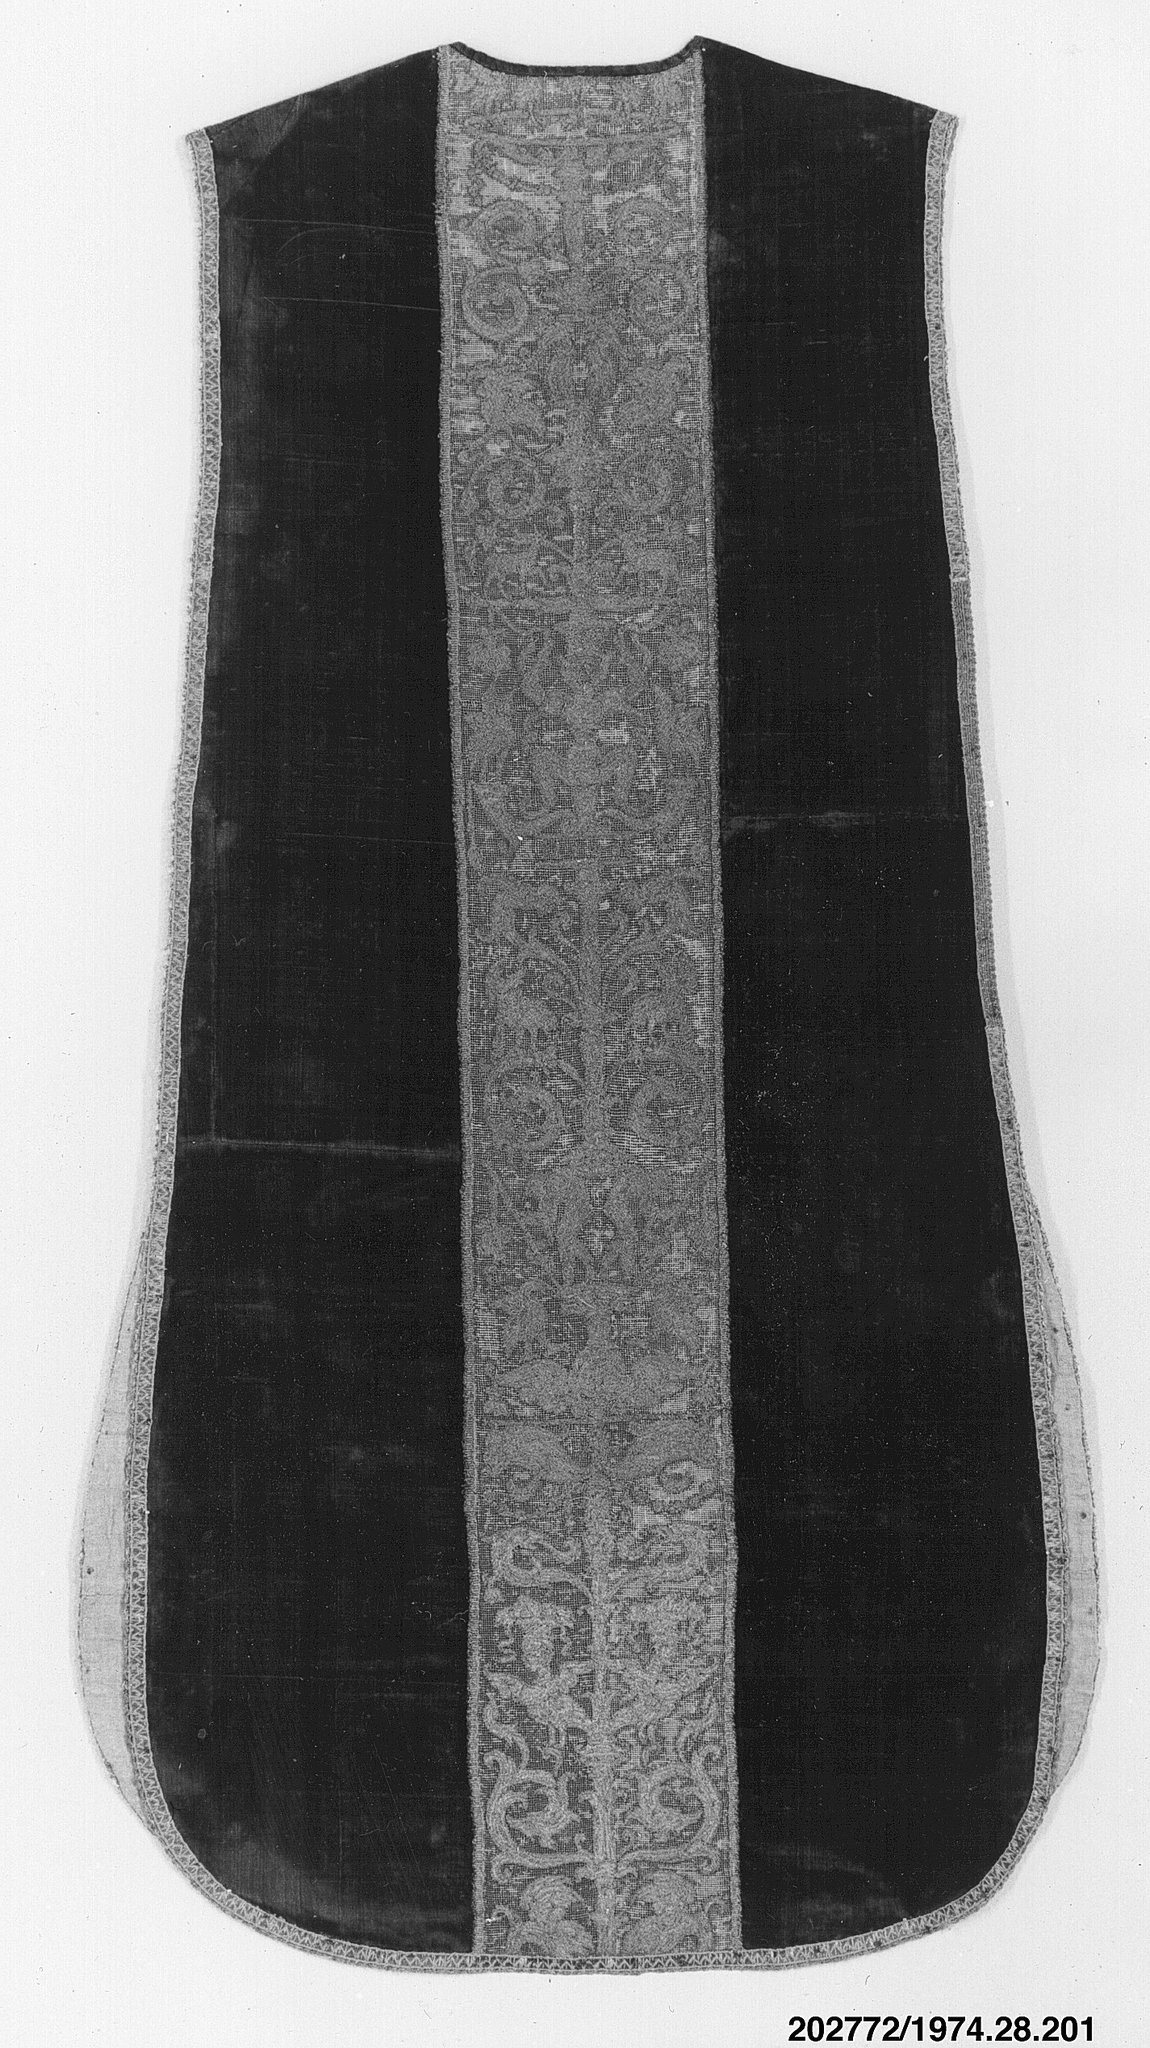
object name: chasuble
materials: linen, metal thread, silk